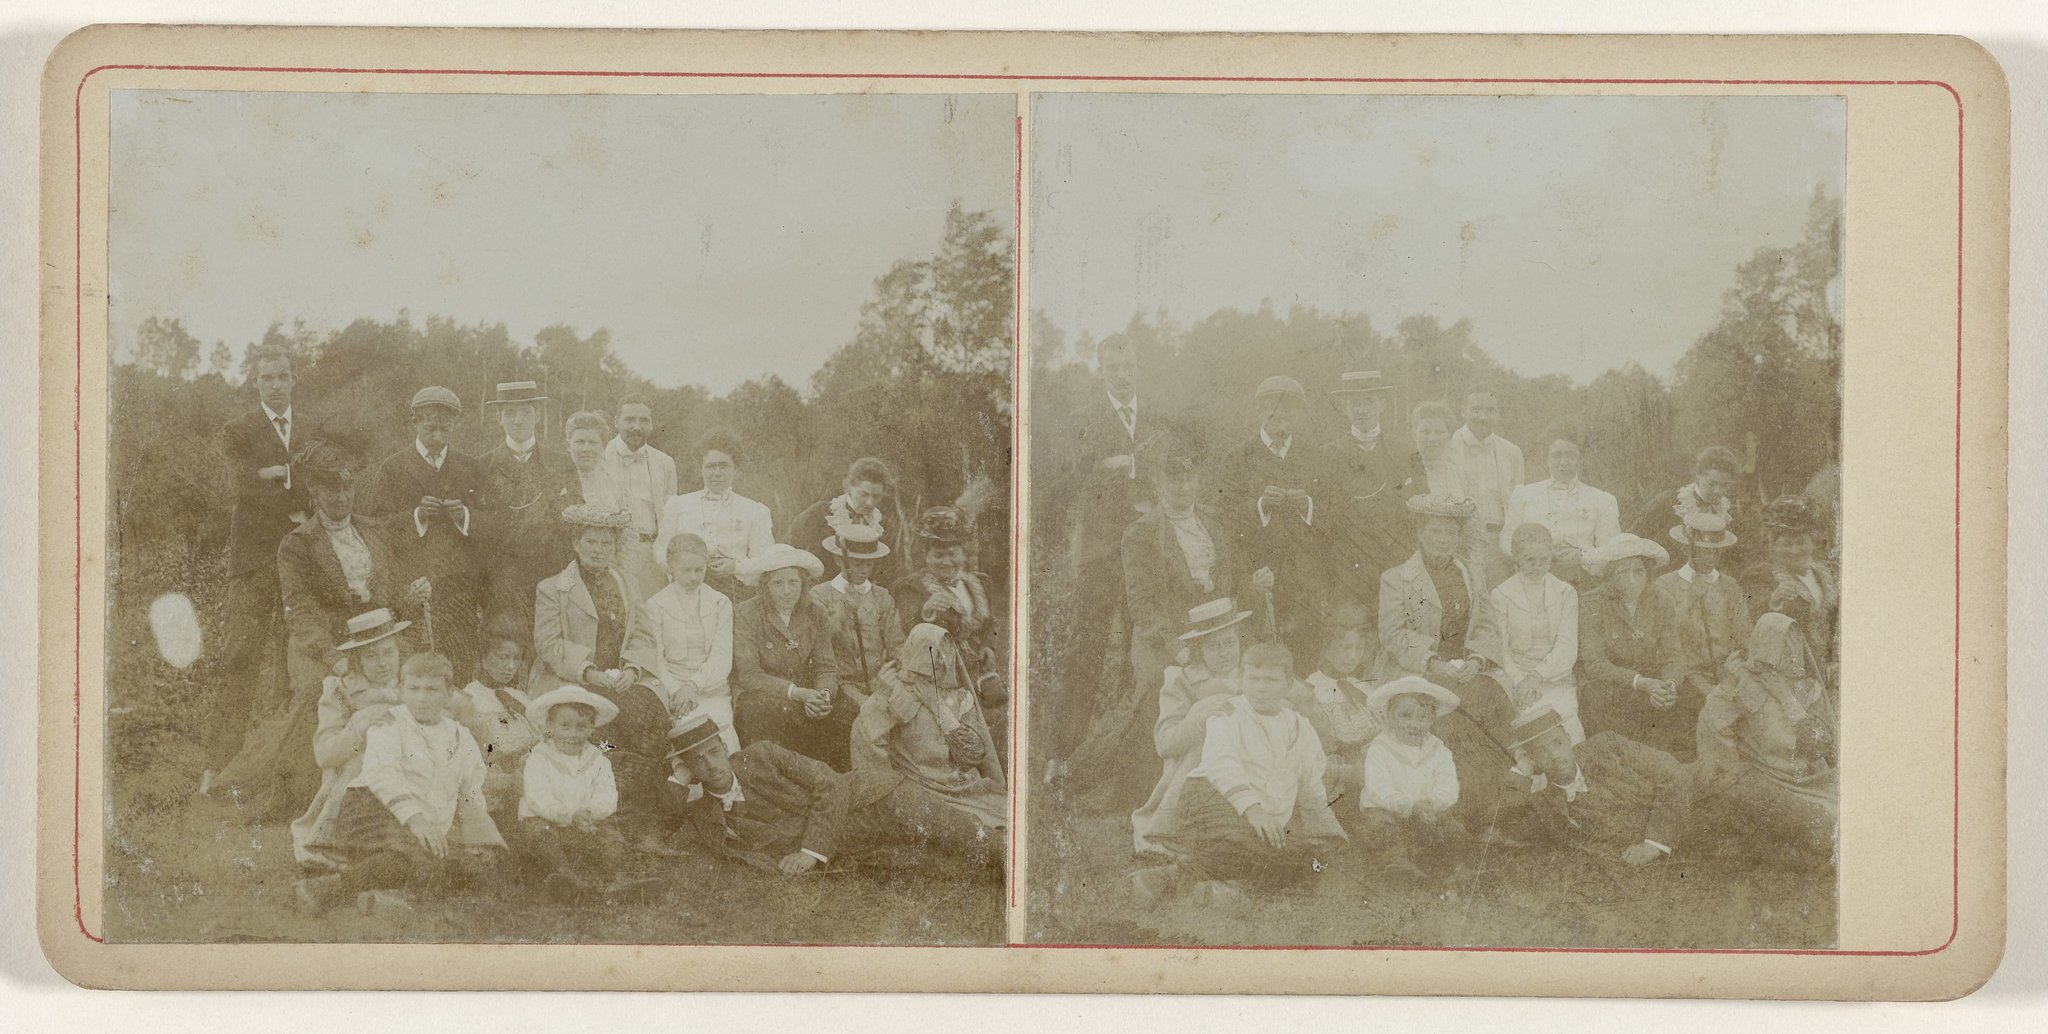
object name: stereograph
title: Groepsportret van de familie Kessler in Homberg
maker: geldolph adriaan kessler (dolph)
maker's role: fotograaf, industrieel, voetballer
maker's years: 1884-1945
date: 1902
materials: paper, photographic support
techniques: collodion silver print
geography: germany